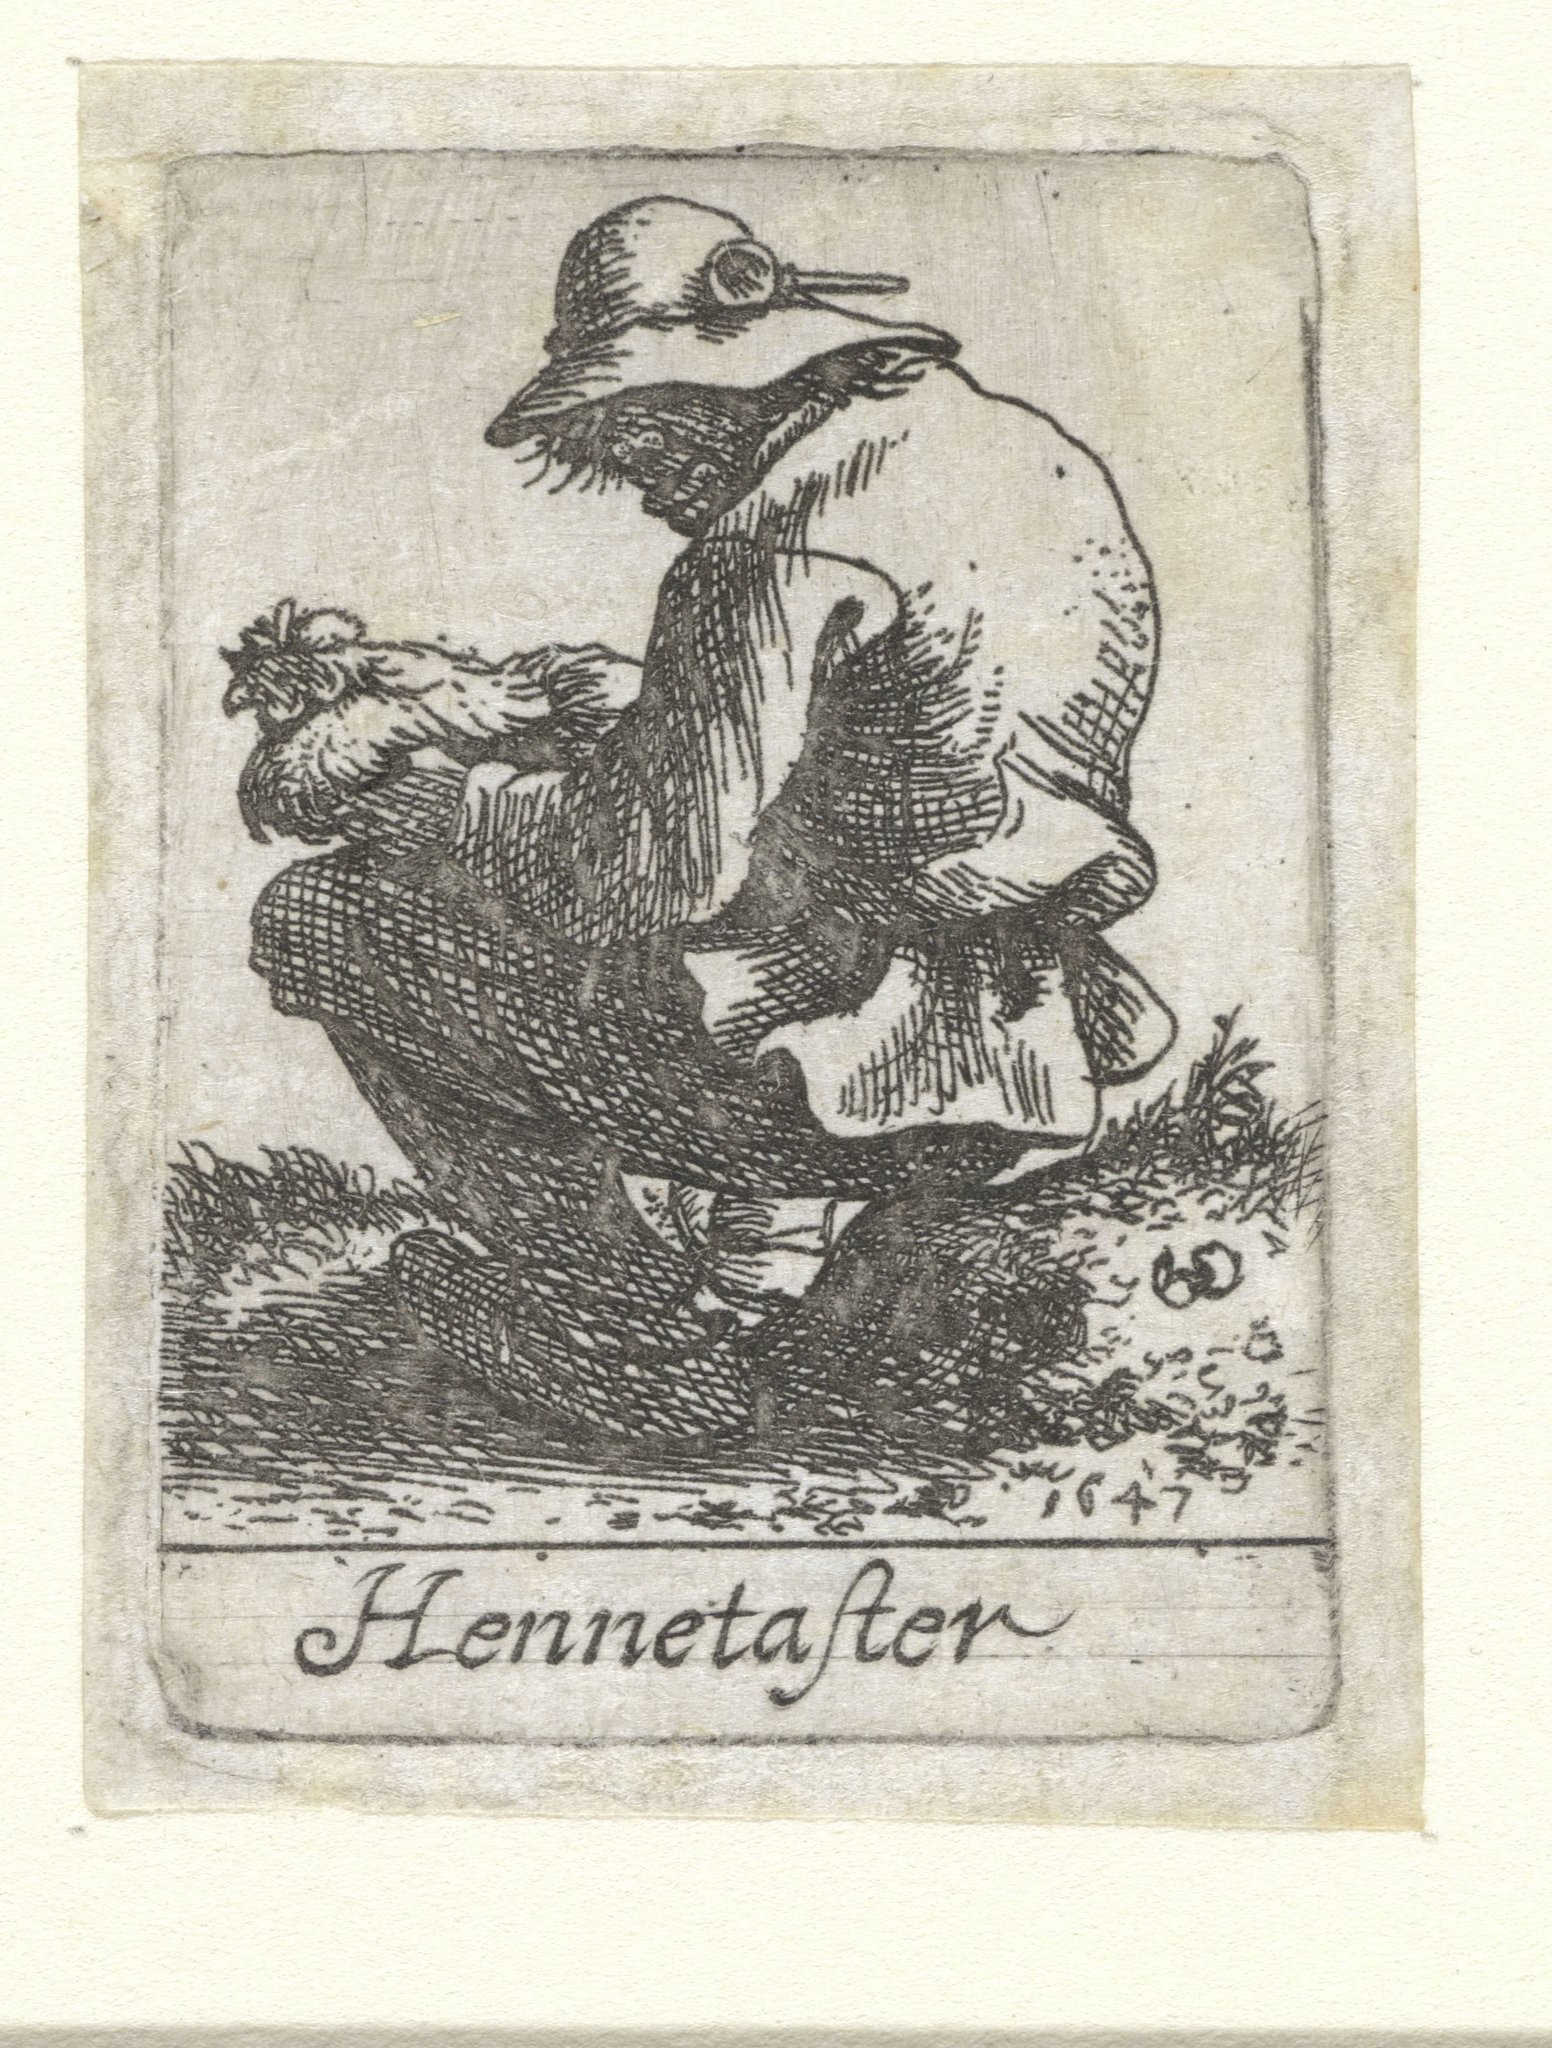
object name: print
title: Hennetaster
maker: herman saftleven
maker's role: draughtsman, painter, print maker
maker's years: 1609-1685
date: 1647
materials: paper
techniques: etching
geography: utrecht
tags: farmers, cleaning fowl or small animals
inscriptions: date: ‘1647’, collector's mark: Lugt 240, monogram: ‘HSL’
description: Een zittende boer plukt de kip die hij op zijn schoot heeft.